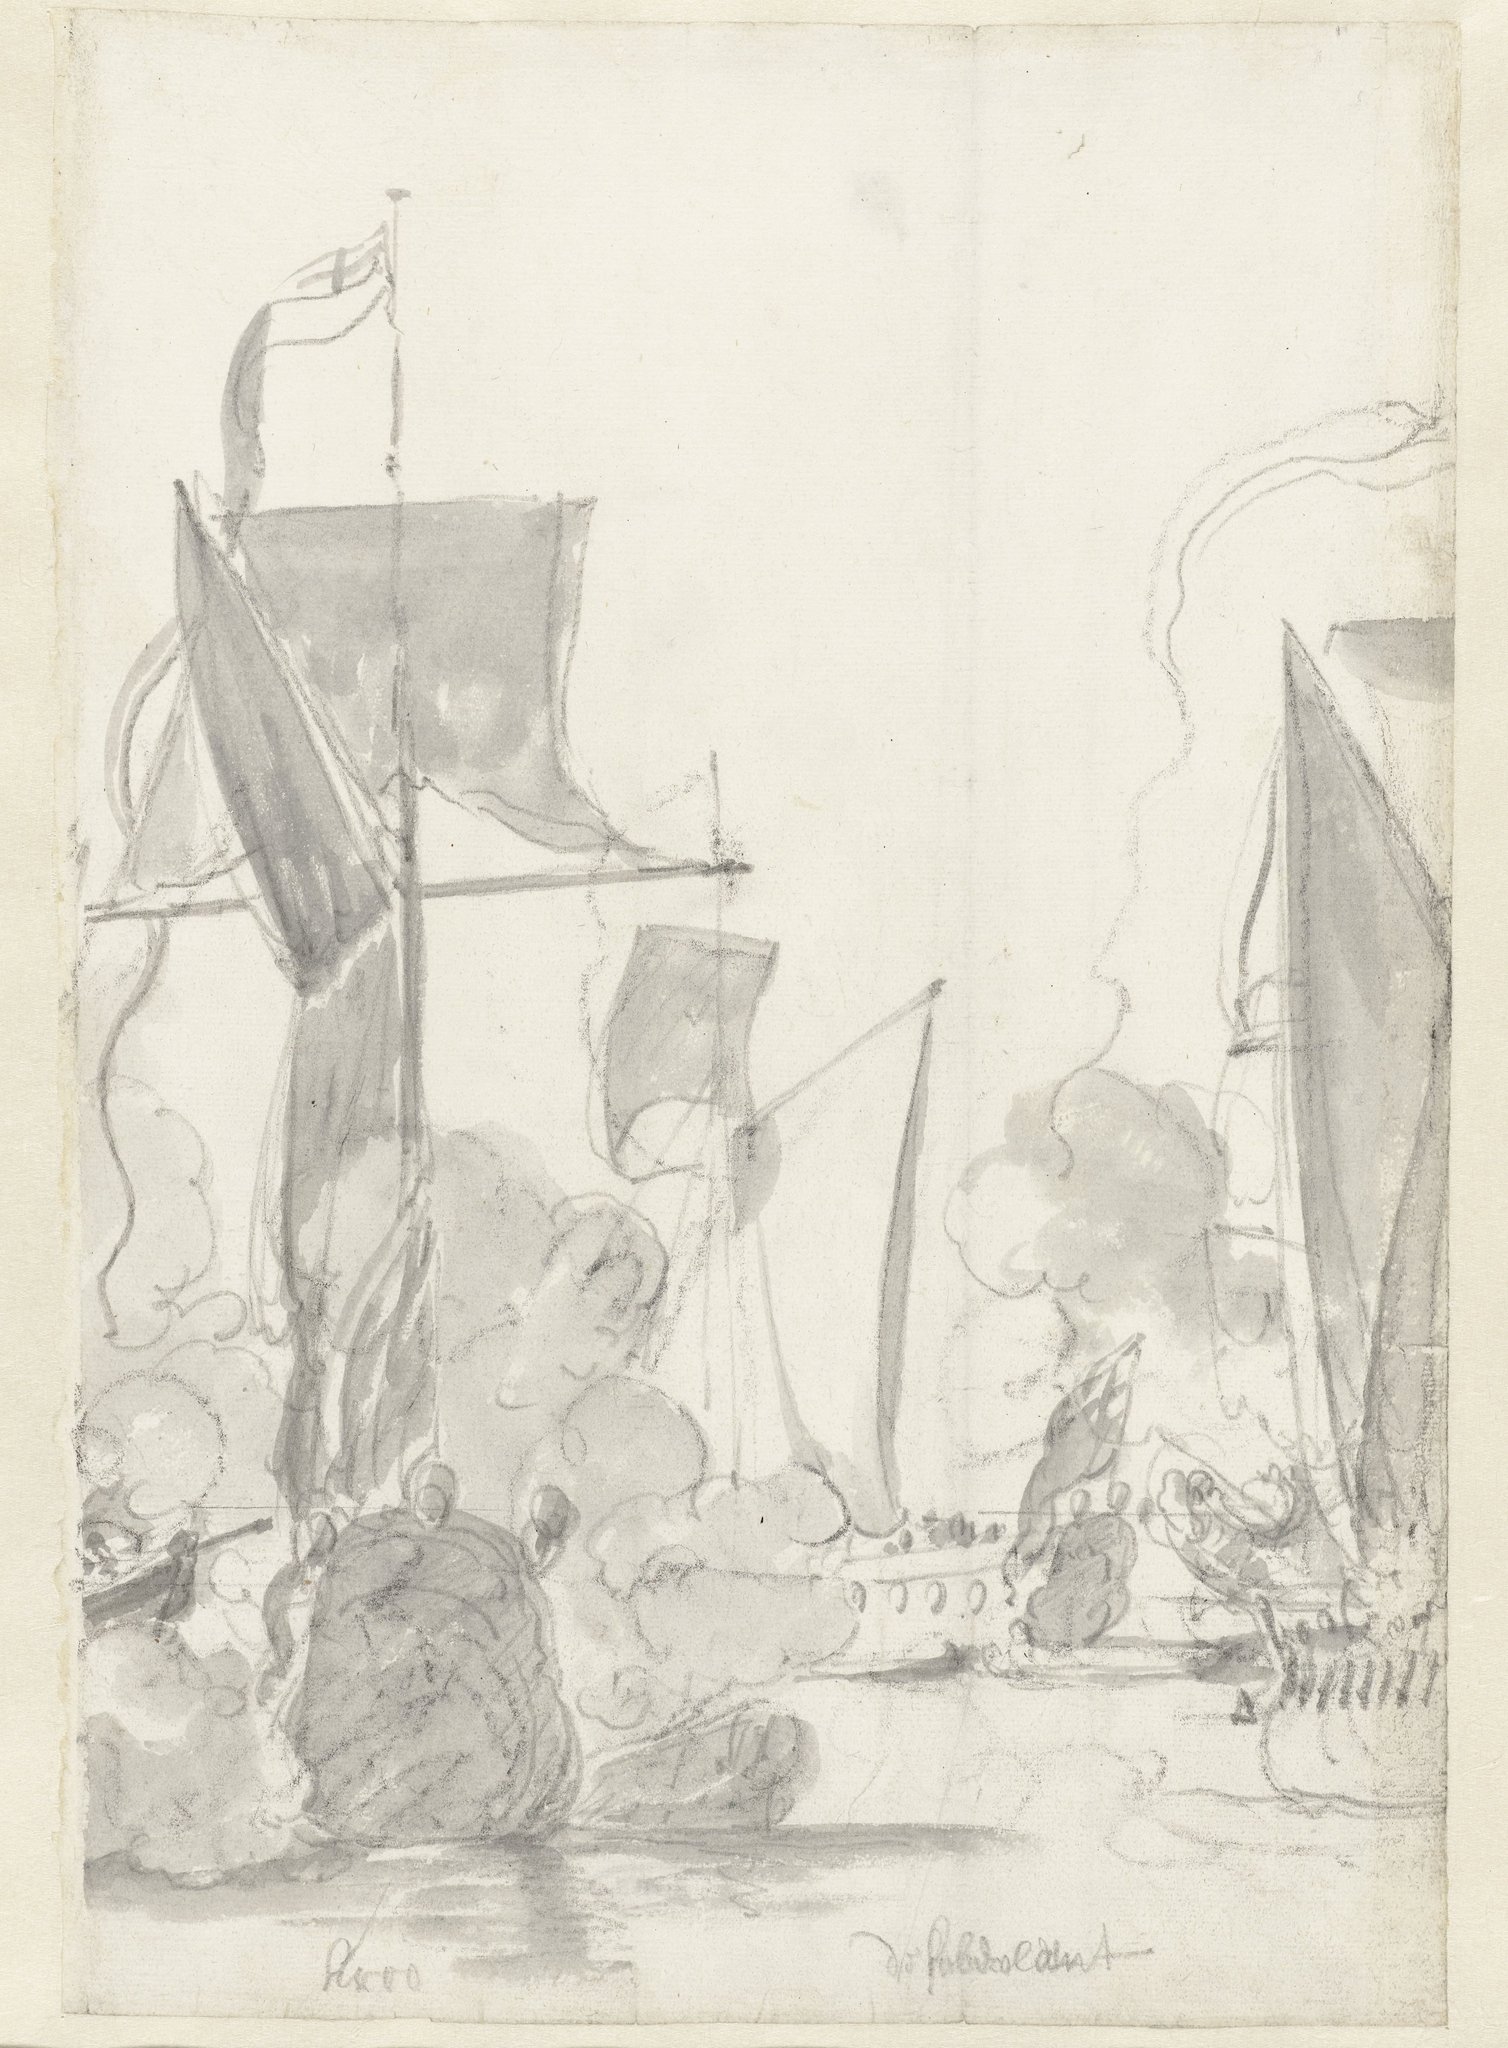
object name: drawing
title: De jachten Kitchen (kroo) en Cleveland (klevelant) tijdens de tocht van de Engelse koning Karel II over de Thames naar Sheerness en Chatham op 27 Augustus 1681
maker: willem van de velde (i)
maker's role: draughtsman, painter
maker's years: 1611-1693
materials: chalk, paper, pencil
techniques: brush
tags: karel ii (koning van engeland), names of artefacts and man-made objects (buildings excluded), visiting; receiving guests; elegant company, sailing-ship, sailing-boat (with name), historical events and situations, thames